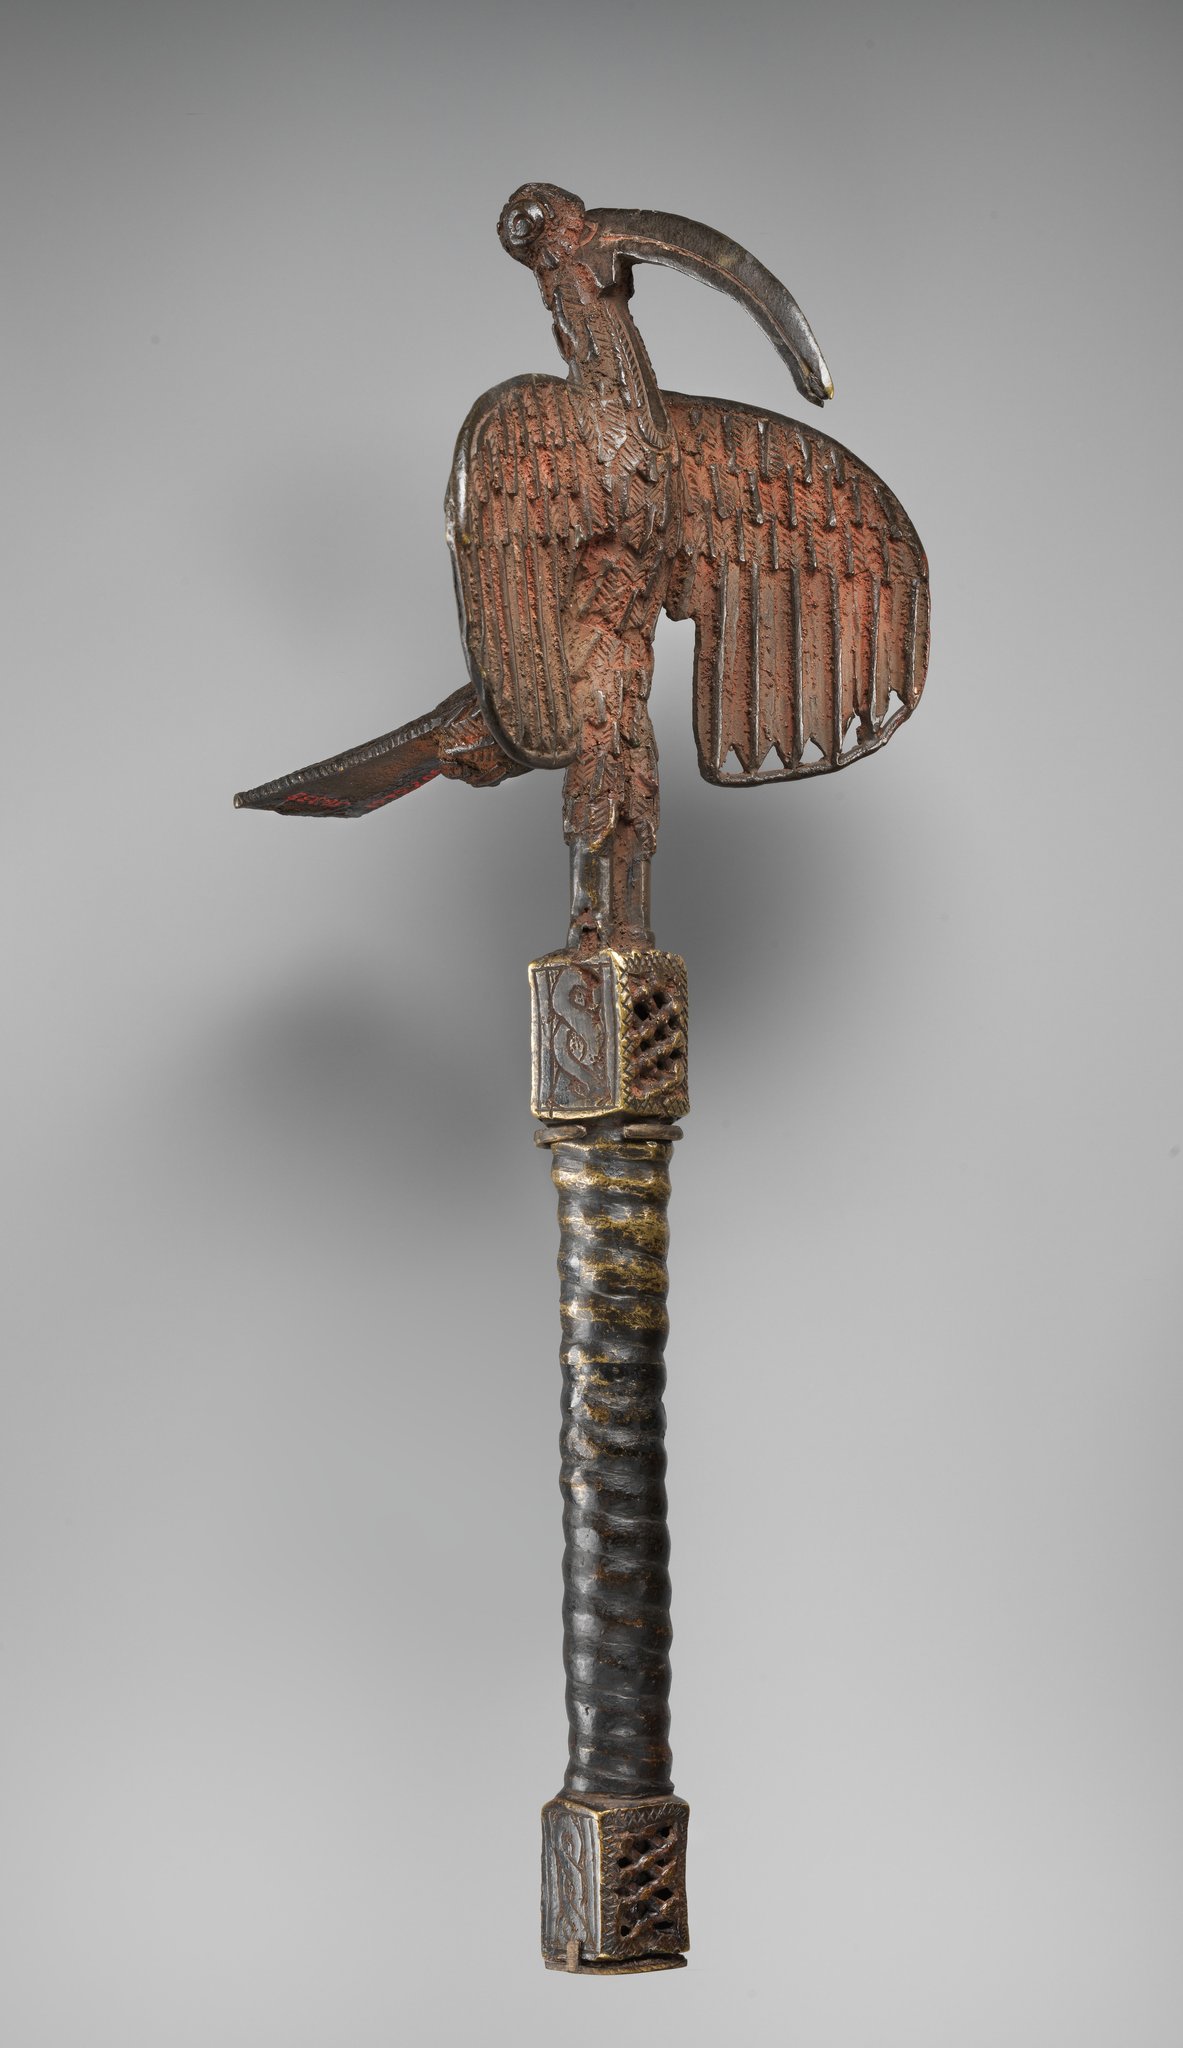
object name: idiophone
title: Idiophone with an áhianmwọ́rọ̀ (bird of prophecy)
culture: edo period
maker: ìgùn ẹ́rọ̀nwwọ̀n (brass-casting guild) artists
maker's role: artist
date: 1501-1600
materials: brass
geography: nigeria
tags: birds